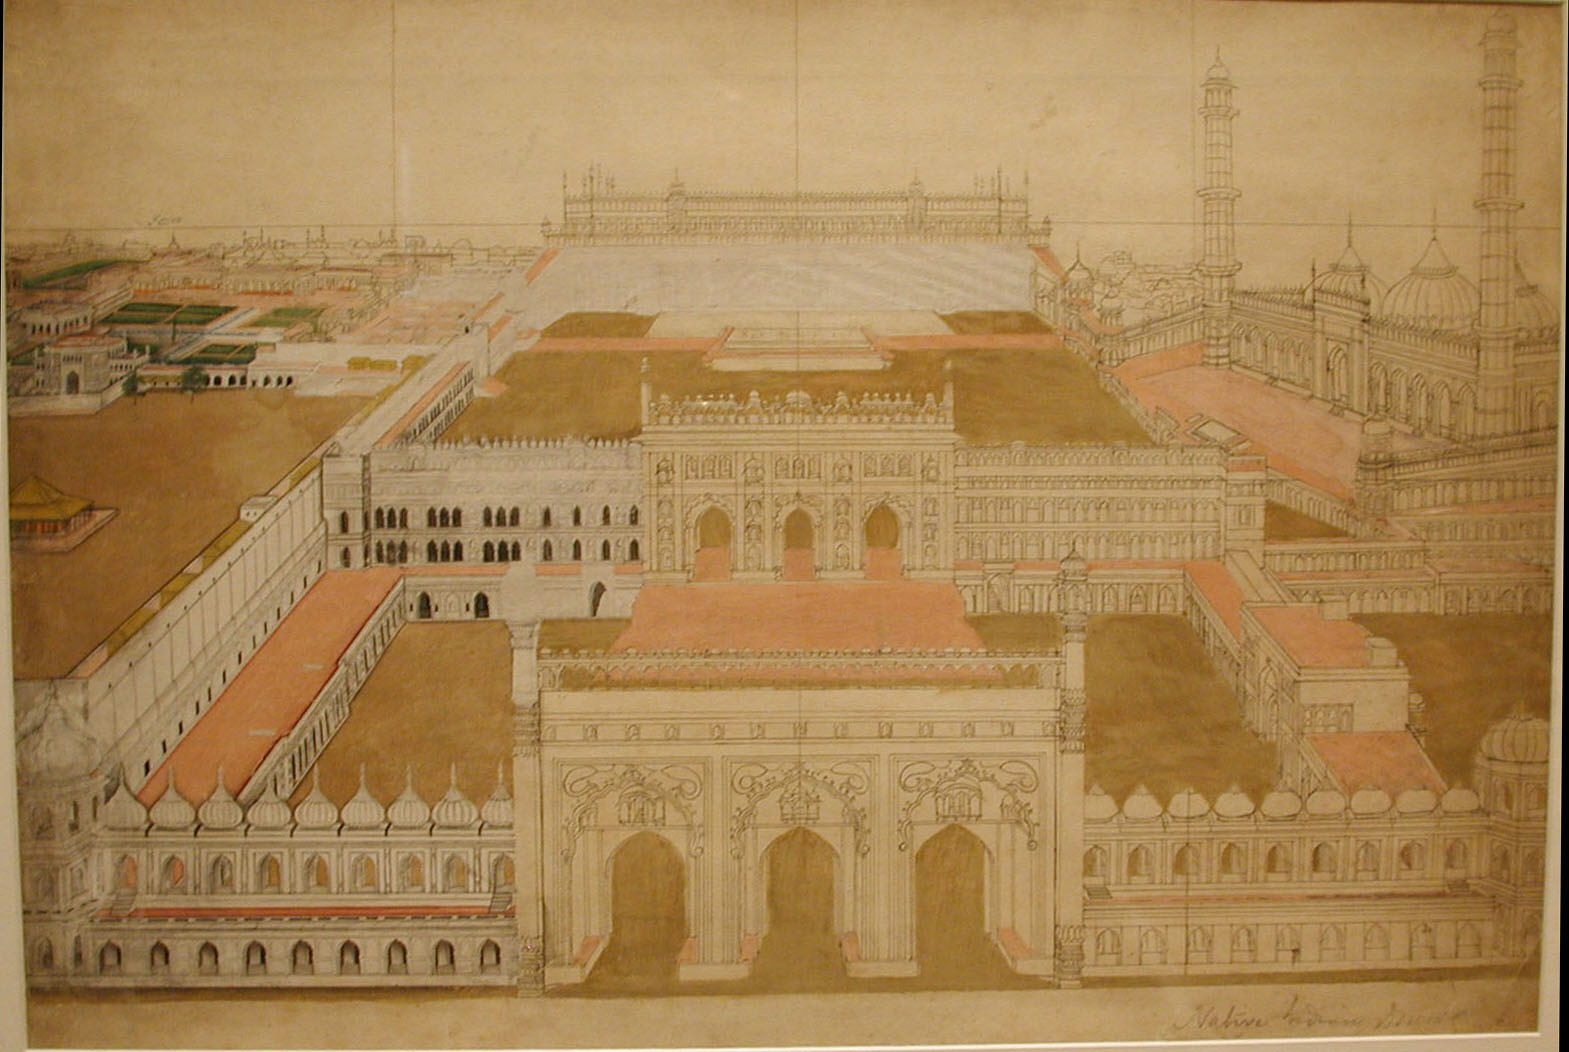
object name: illustrated single work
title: The Bara Imambara Complex at Lucknow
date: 1800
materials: ink, paper, watercolor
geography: india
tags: architecture,mosques